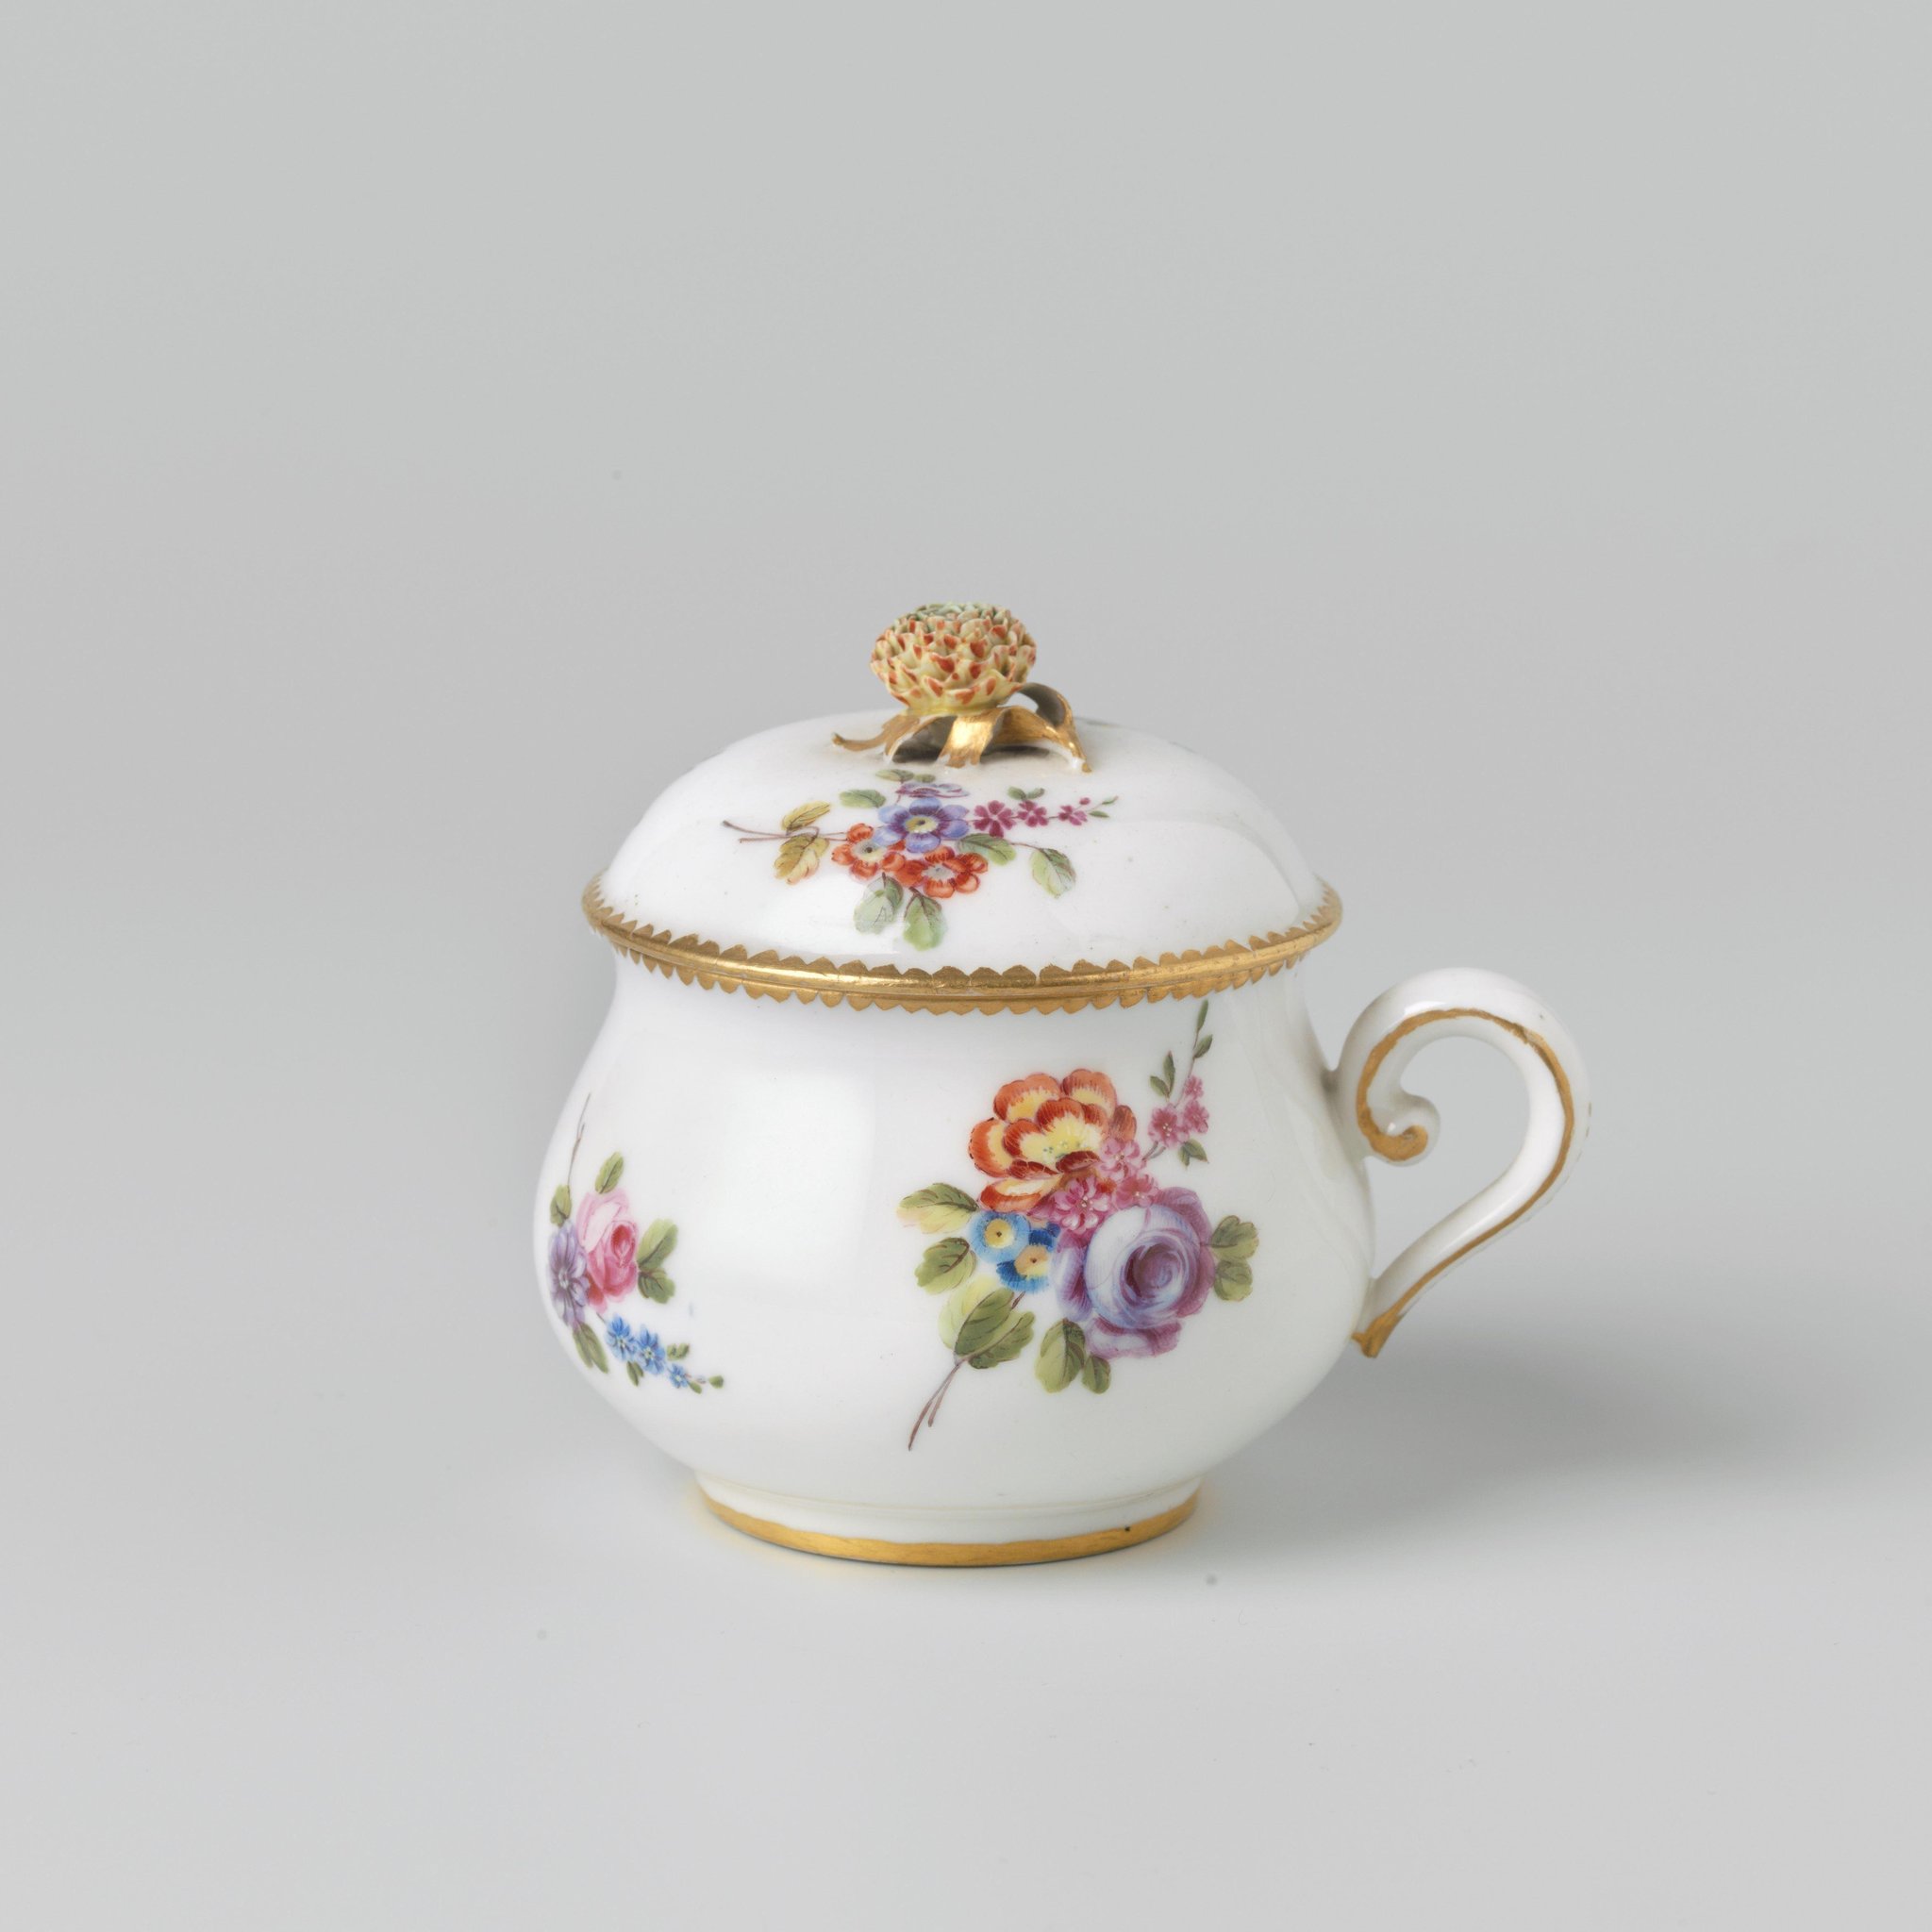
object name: covered jar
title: Covered pot with bouquets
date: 1760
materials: glaze, gold, paint, porcelain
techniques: firing, forming, gilding, turning, vitrification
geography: sèvres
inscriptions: mark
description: Dekselpot (roompot) van porselein met een gedrukt peervormig lichaam en gekruld oor, beschilderd op het glazuur in blauw, rood, roze, groen, geel, paars, zwart en goud. De buik is versierd met verschillende boeketten. Gouden lijn op de voet en de zijkant van het oor. Op de nek een decoratieve band in goud. Gemerkt op de onderzijde met de dubbele L met jaarletter G, waaronder vier stippen in de vorm van een ruit.